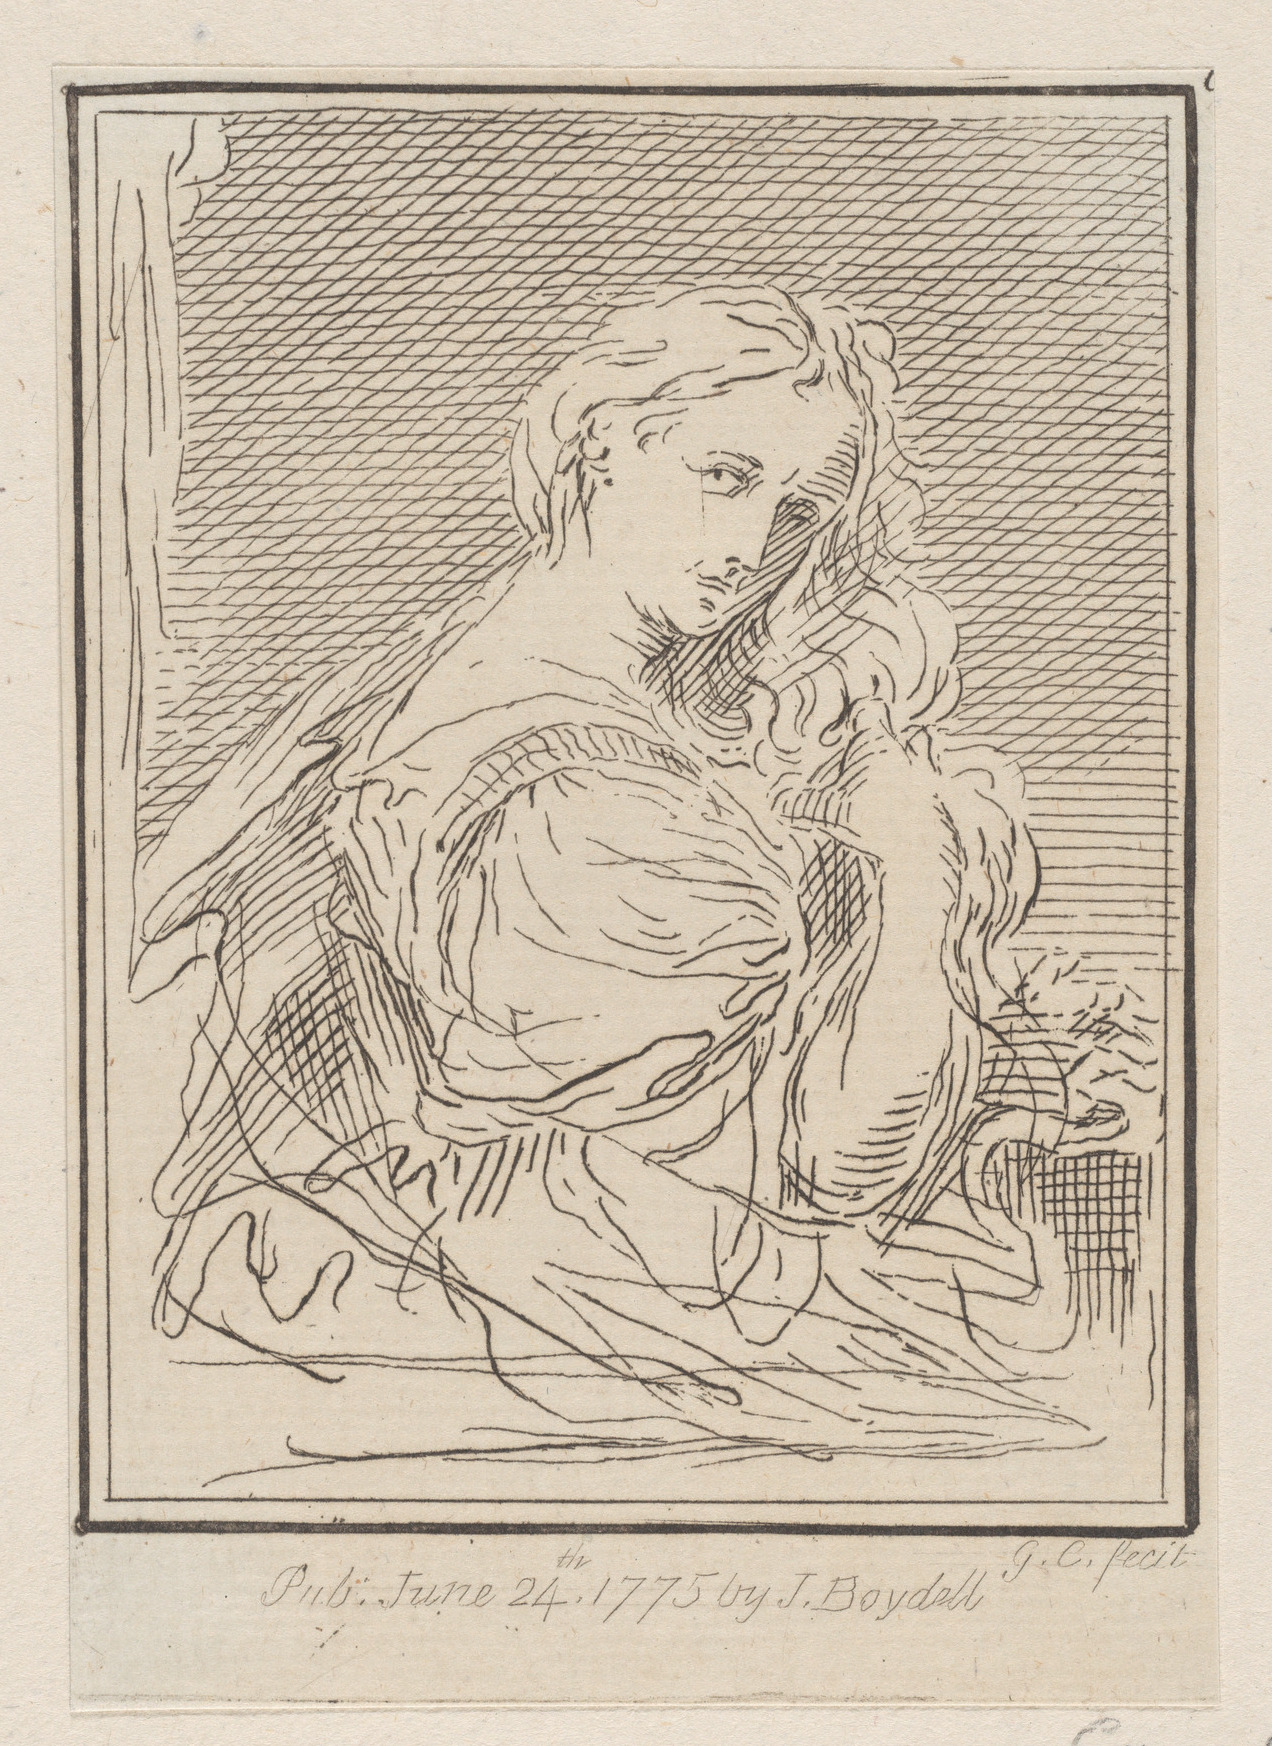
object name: print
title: Woman combing her hair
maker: giuseppe canale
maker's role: artist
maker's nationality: italian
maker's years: 1725-1802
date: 1775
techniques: etching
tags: women